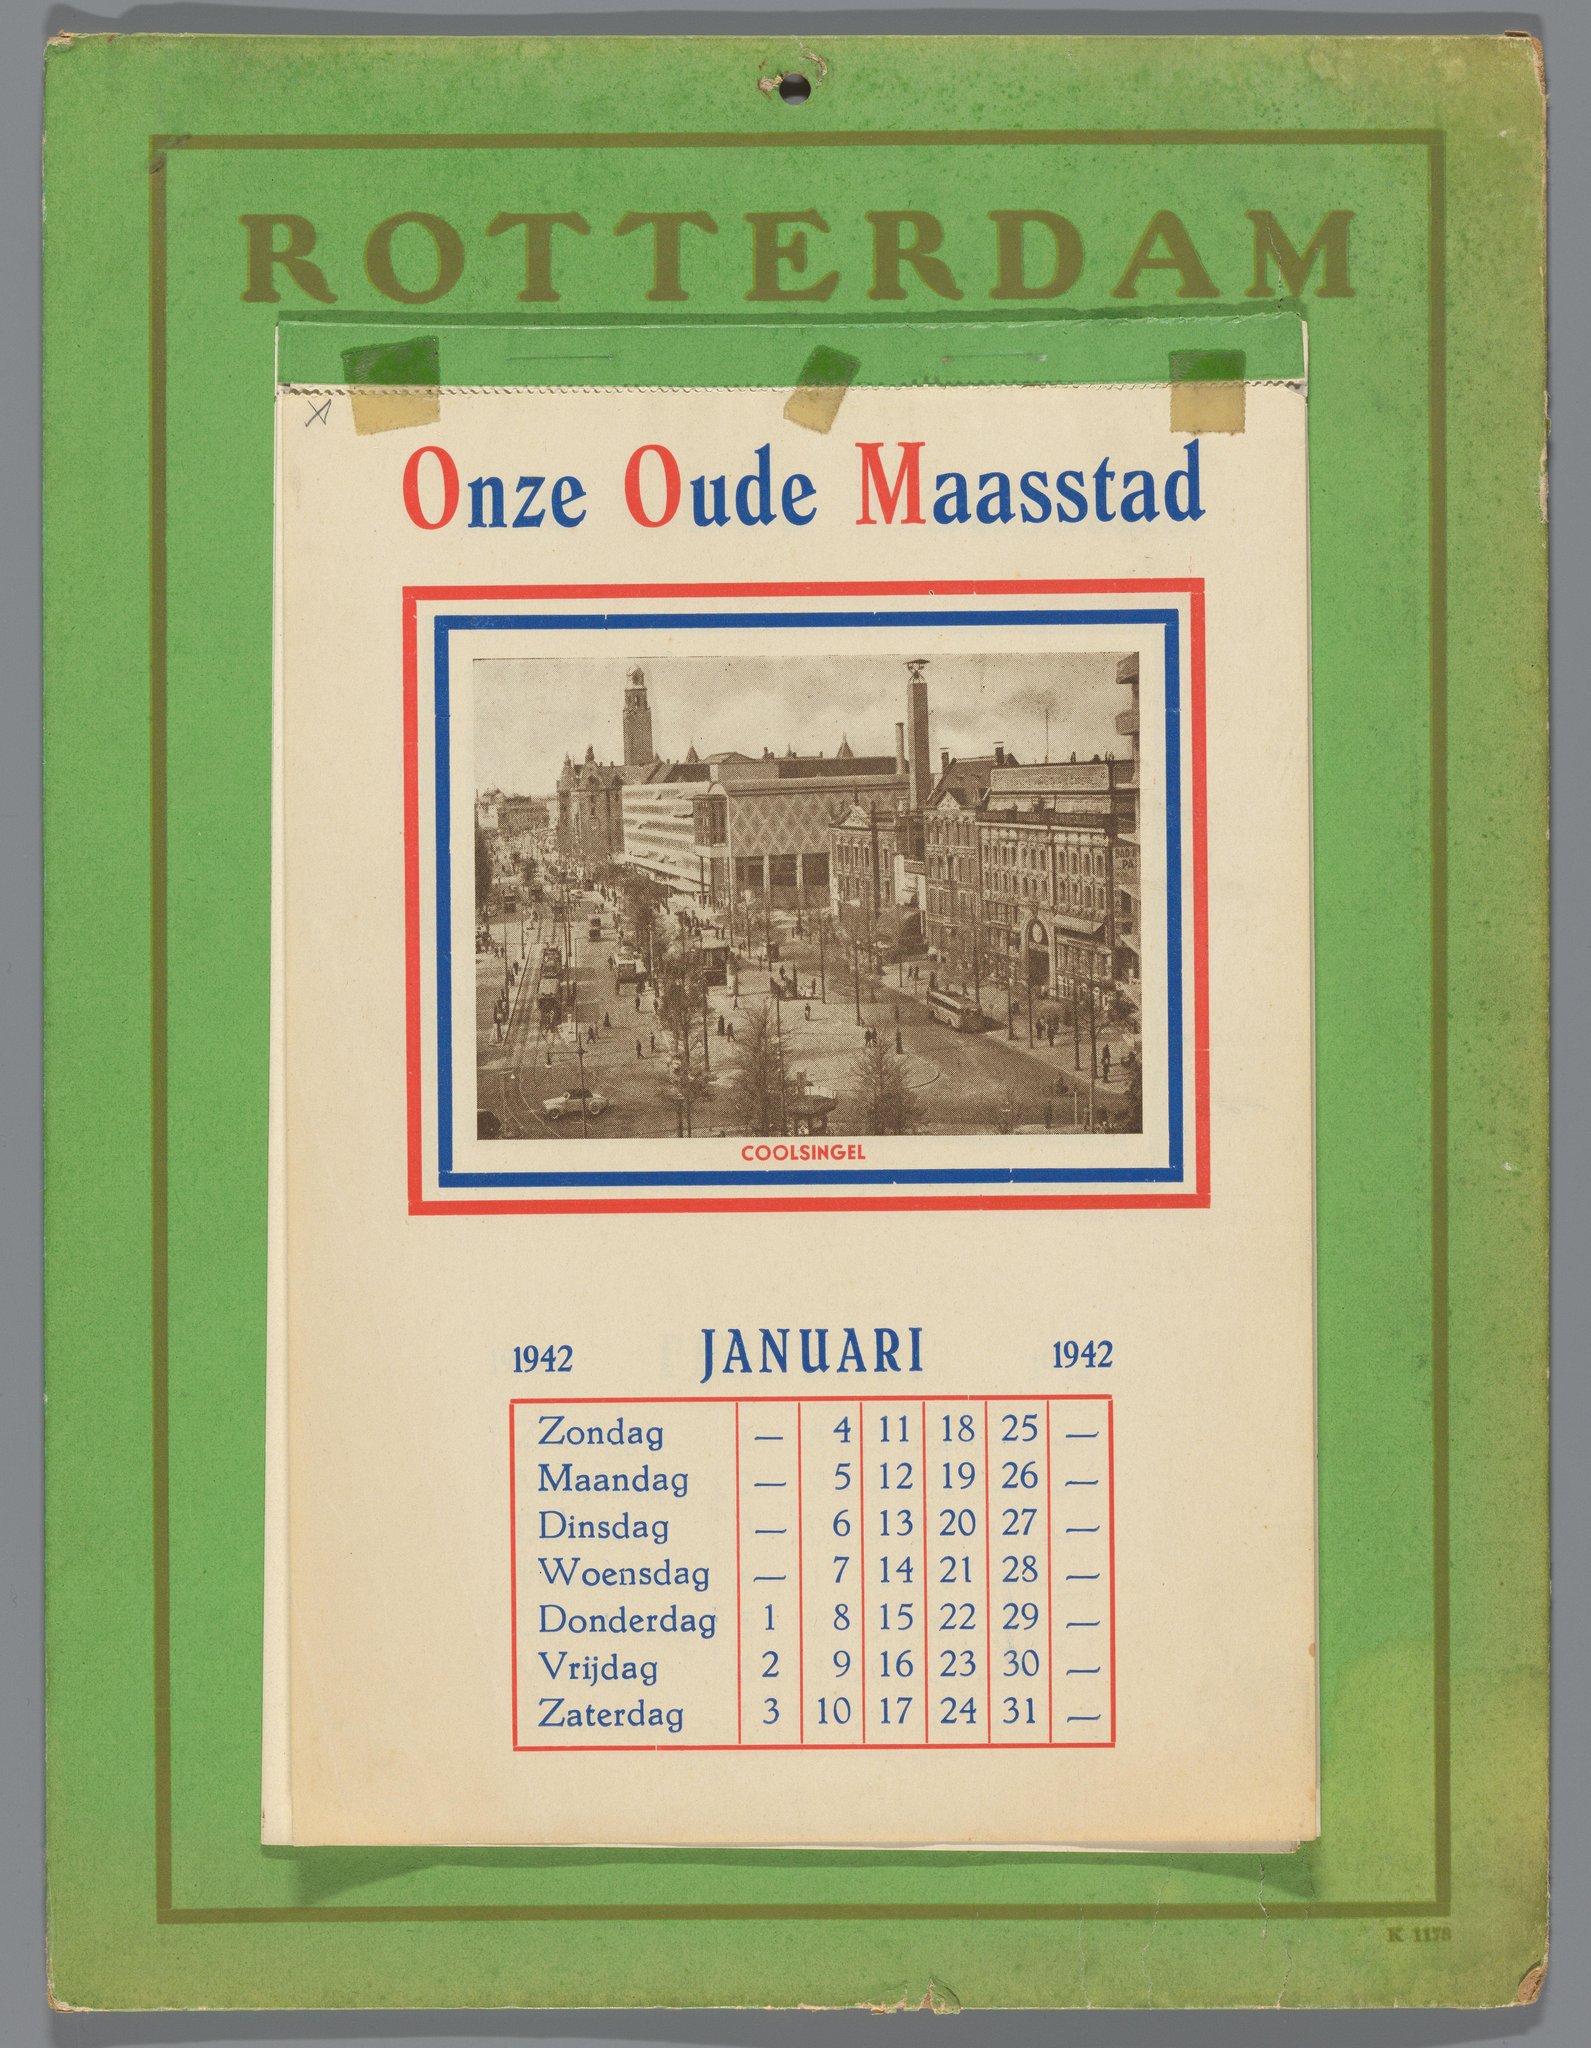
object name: photomechanical print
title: Rotterdam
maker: Anonymous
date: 1942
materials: cardboard, paper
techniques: printing block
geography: rotterdam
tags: city-view in general; 'veduta'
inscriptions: inscription: ‘F. J. M. Film Mij./ Korte Poten 27. Den Haag’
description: Kalender van het jaar 1942 met 12 stadsgezichten van Rotterdam